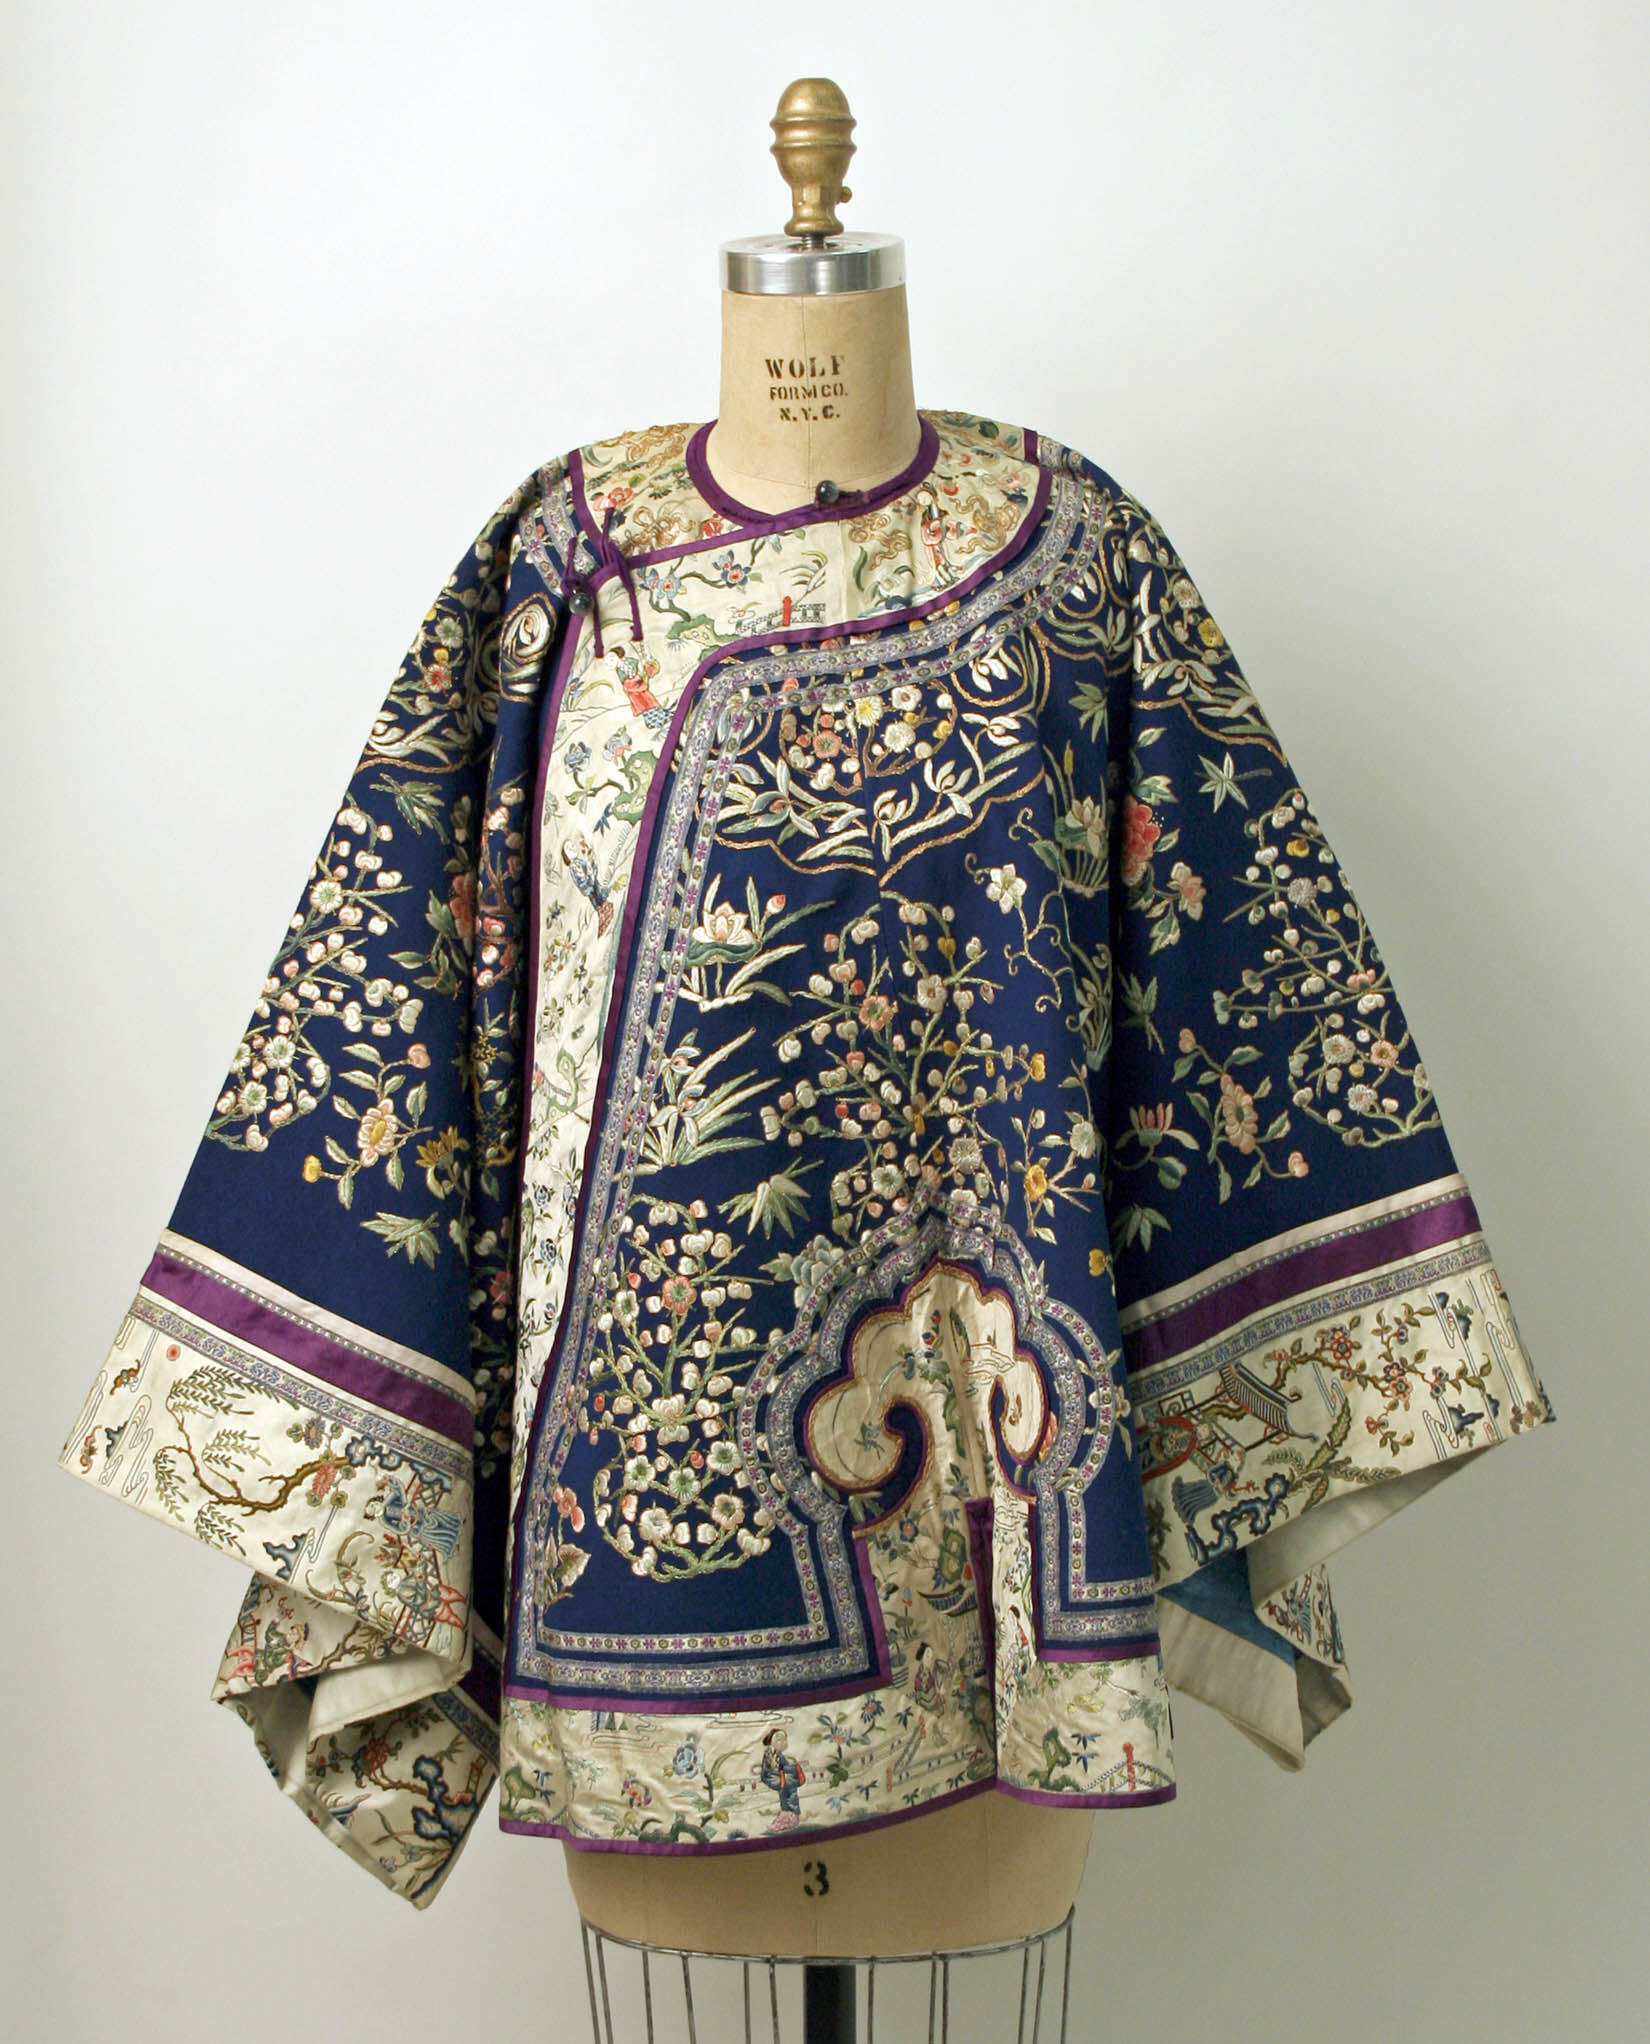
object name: coat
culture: chinese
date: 1850-1900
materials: metal, silk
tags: flowers